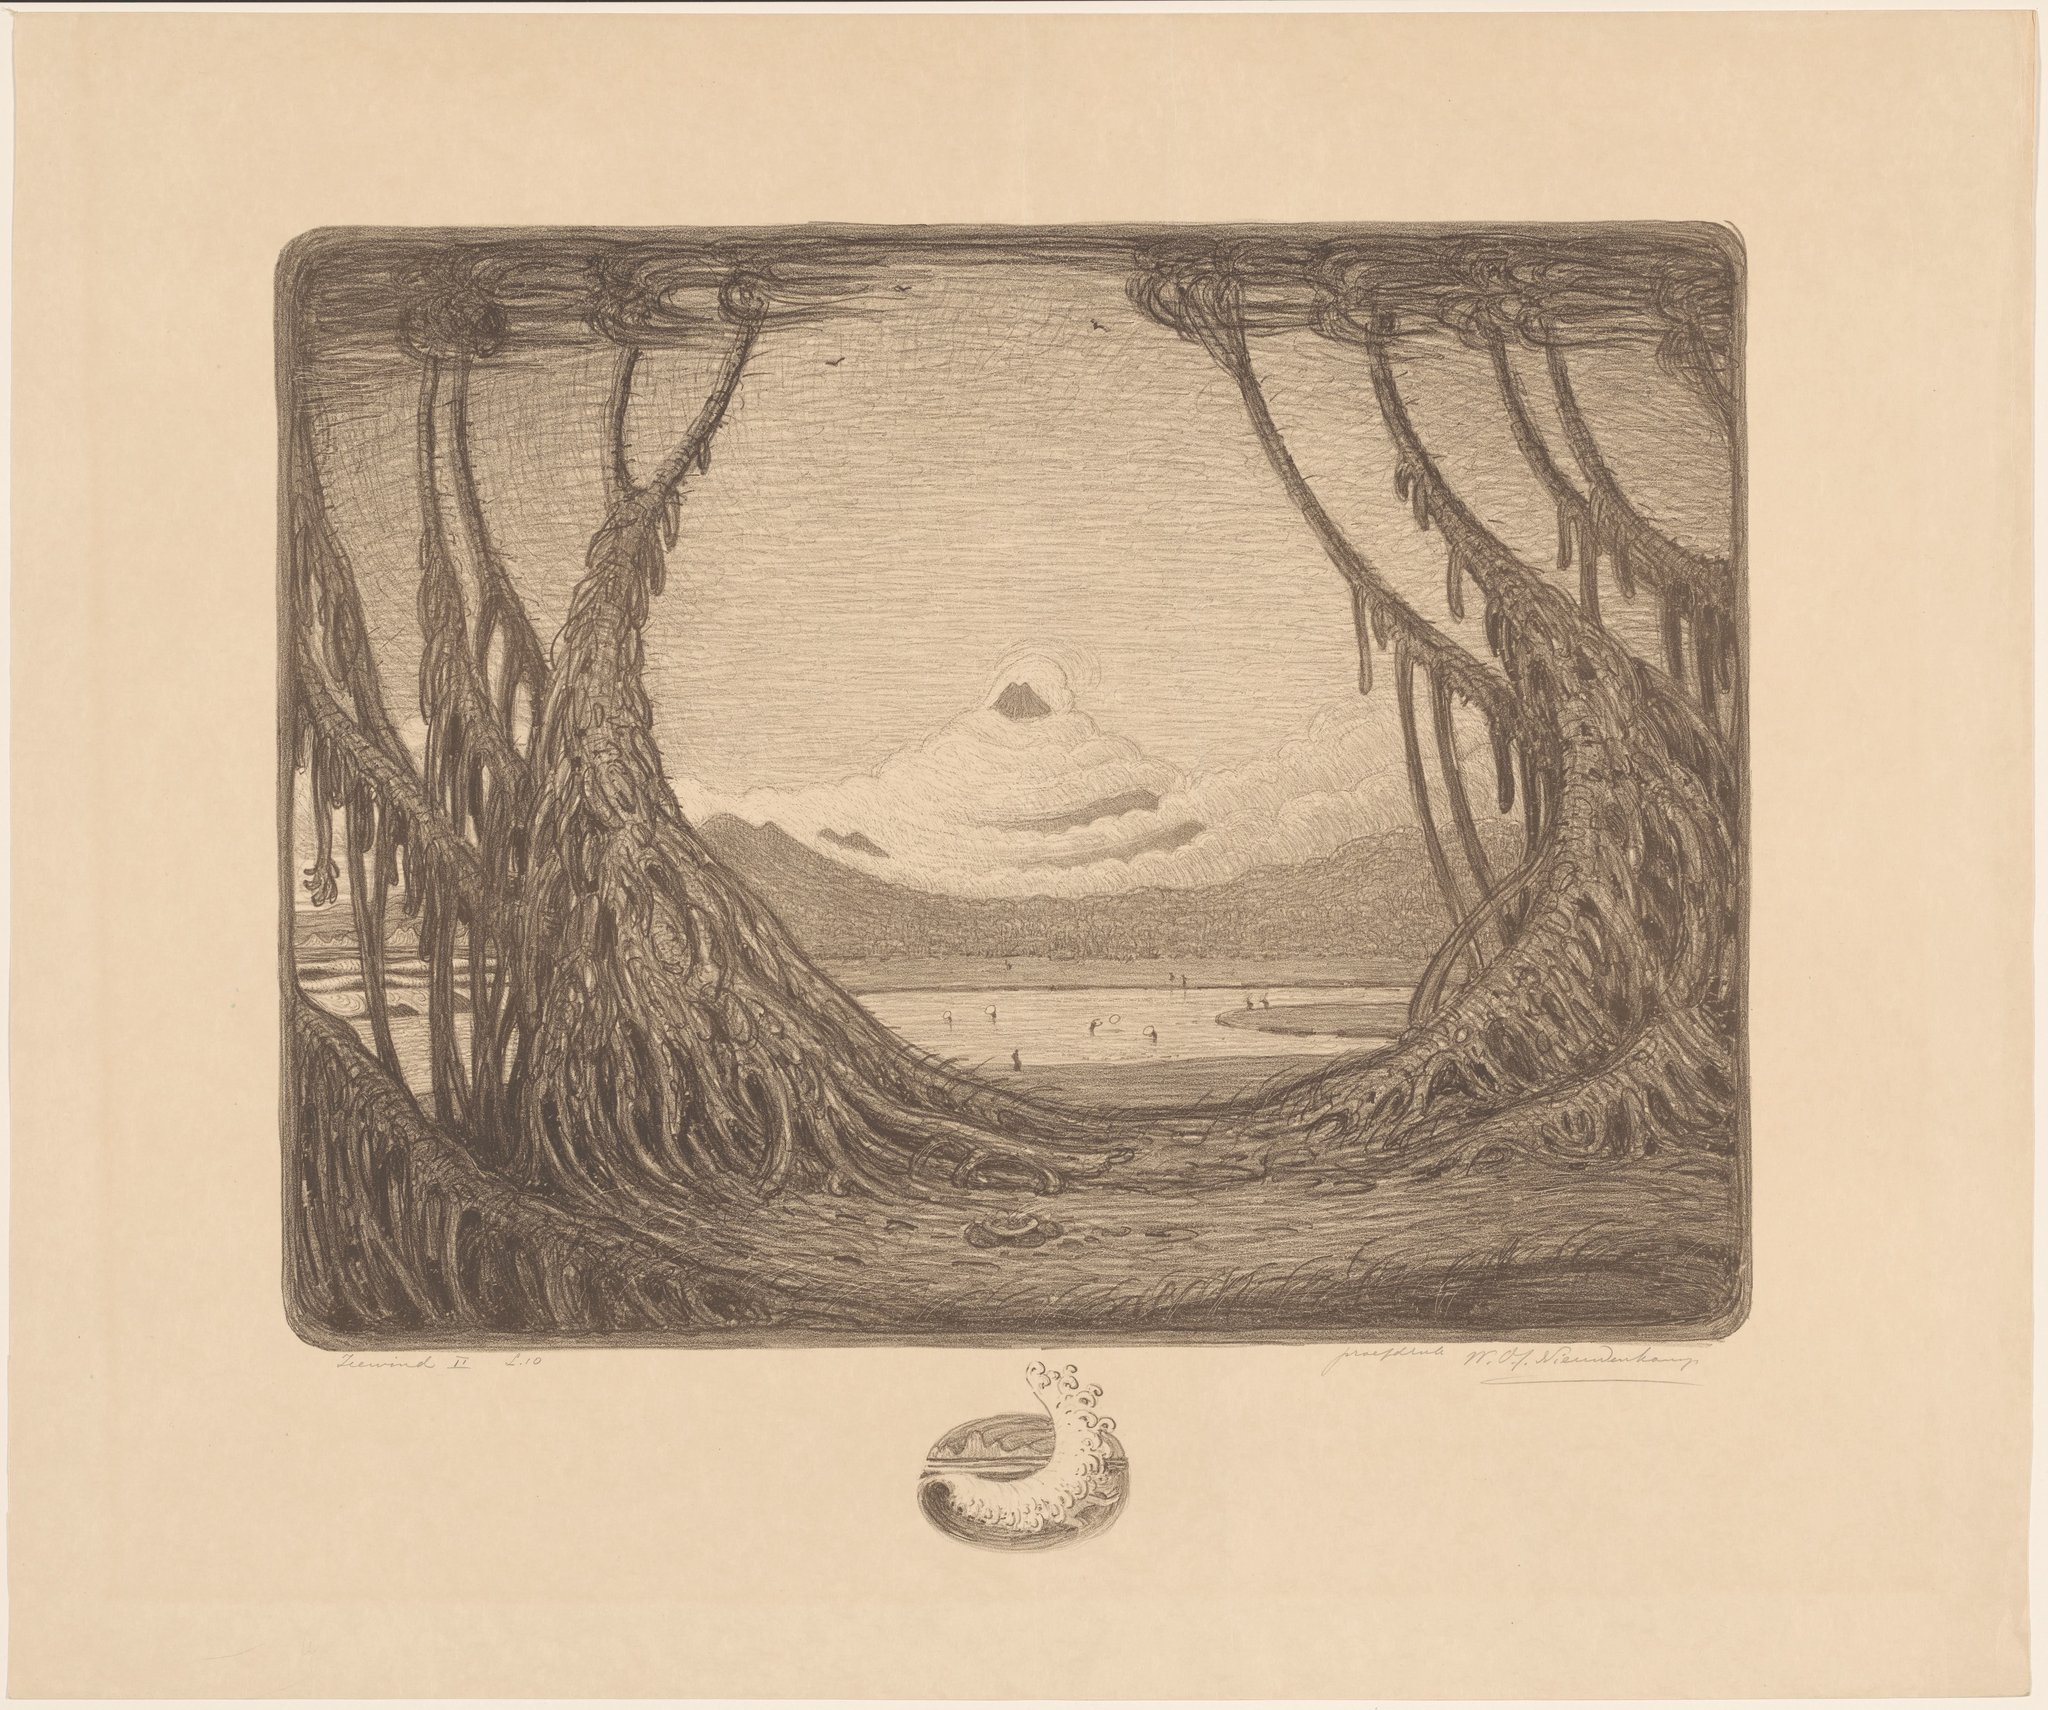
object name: print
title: Zeewind II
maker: wijnand otto jan nieuwenkamp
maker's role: draughtsman, print maker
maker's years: 1874-1950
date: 1904-1918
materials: paper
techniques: lithograph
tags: sea (+ landscape with figures, staffage), java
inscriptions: collector's mark: Lugt 2233